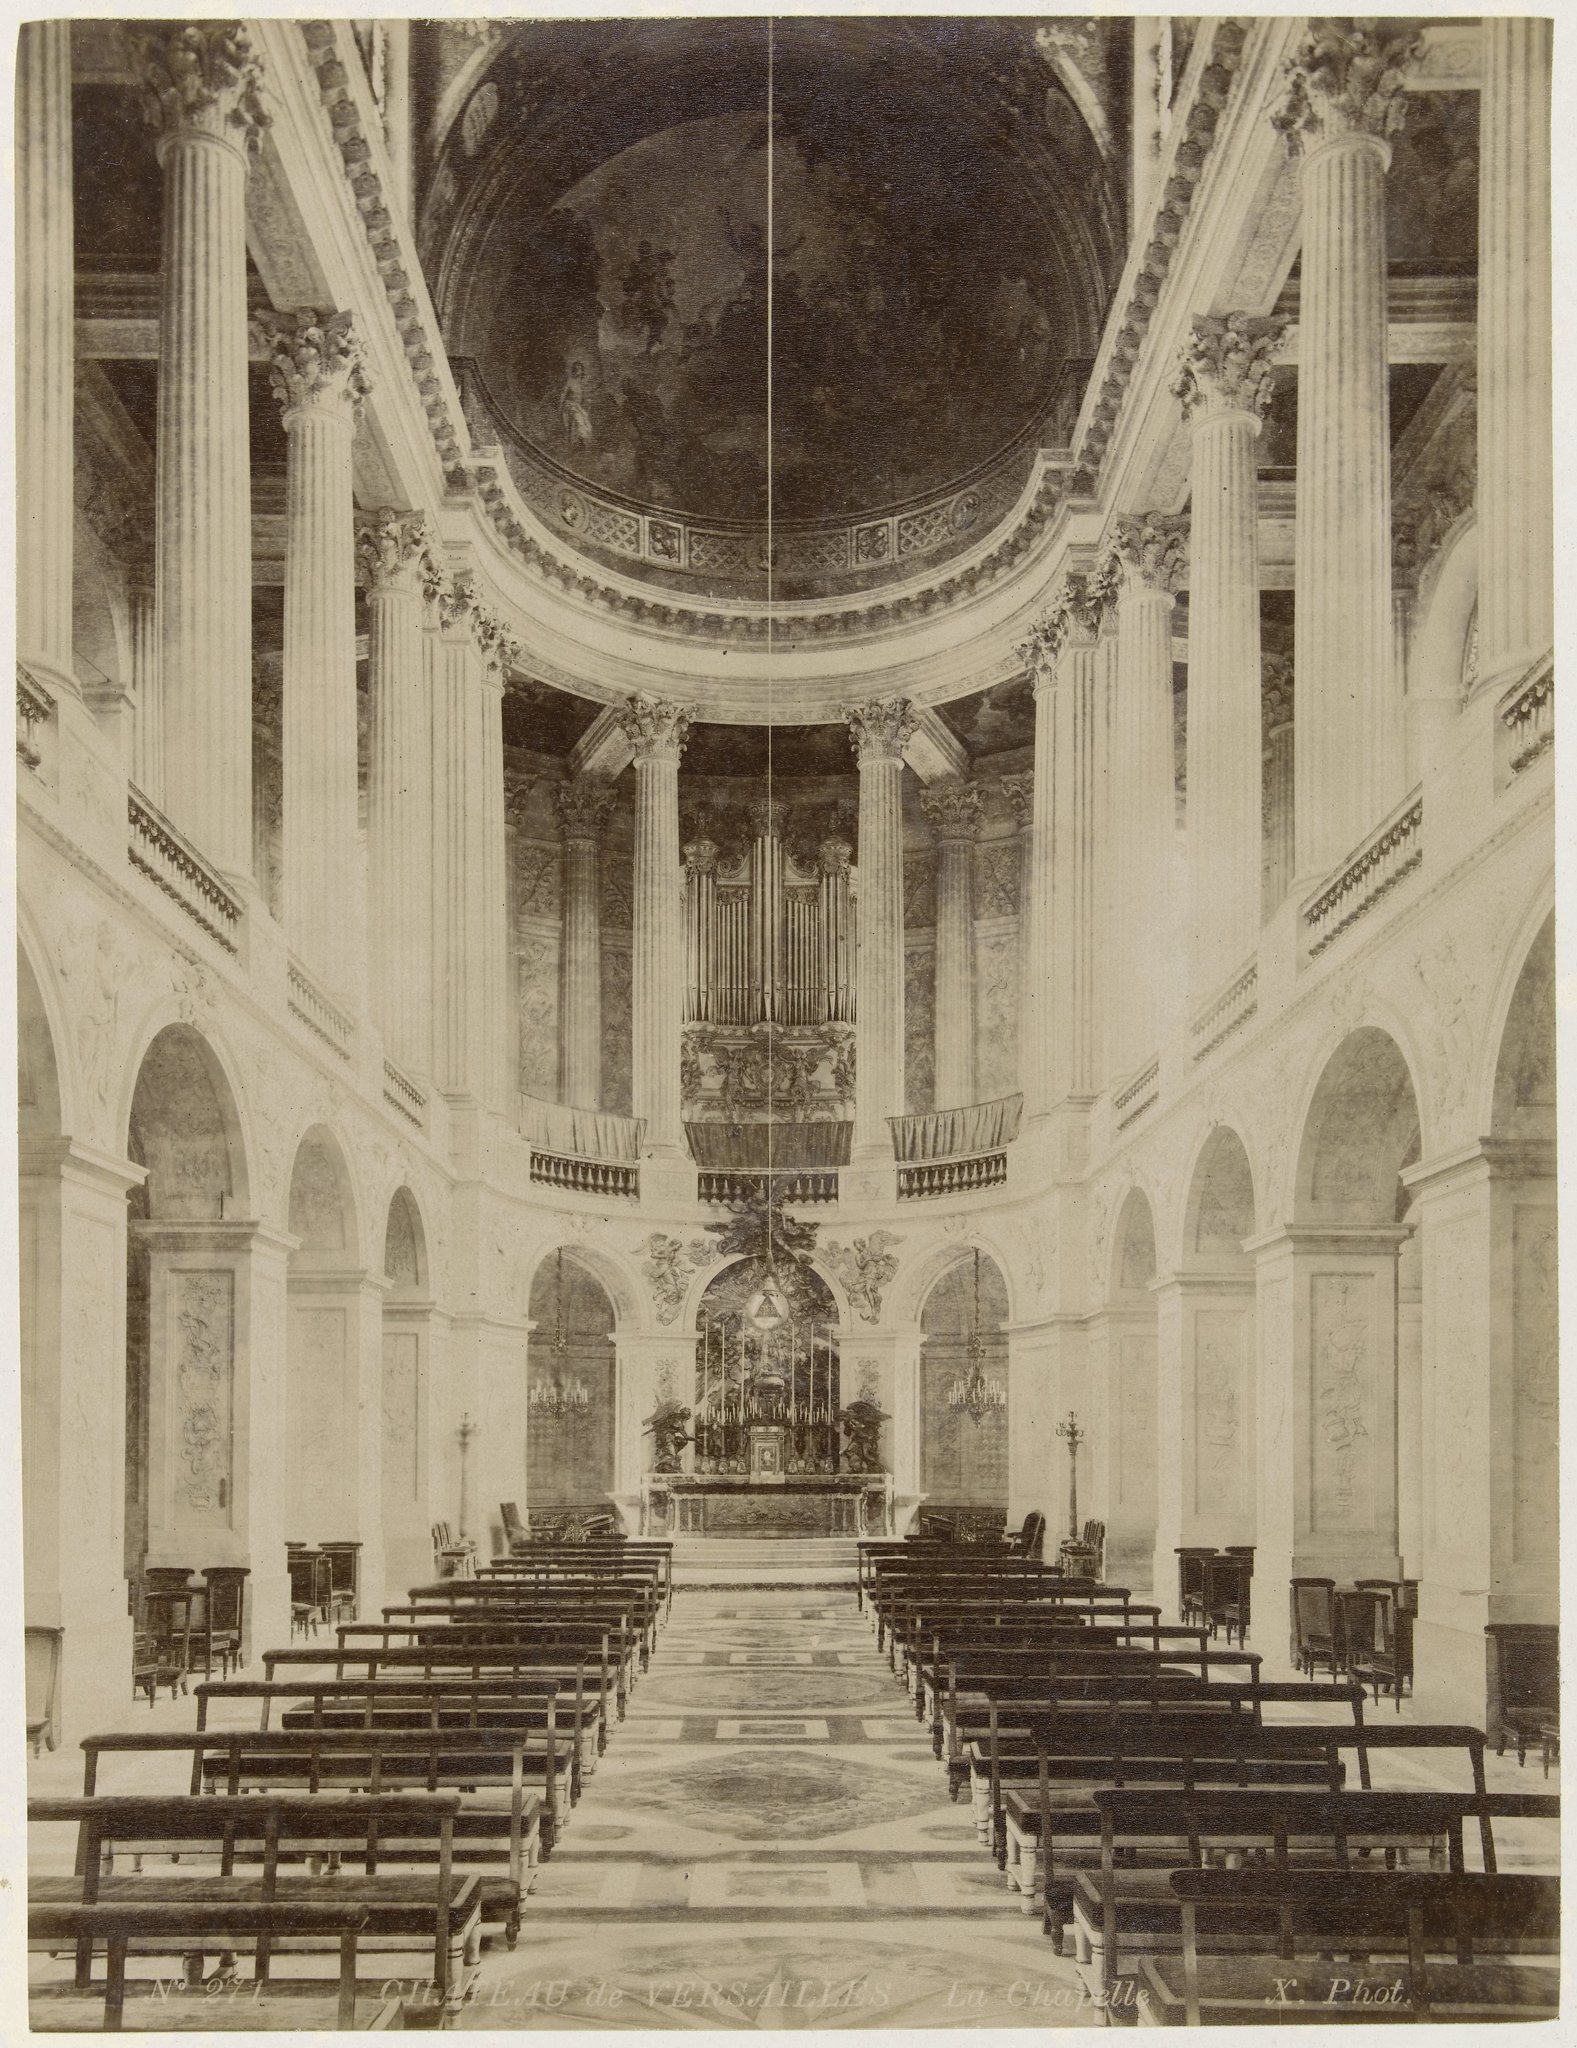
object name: photograph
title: Kapel in het paleis van Versailles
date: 1887-1900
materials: cardboard, paper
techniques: albumen print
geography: versailles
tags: interior of church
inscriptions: inscription: ‘No 271. Château de Versailles. La Chapelle X. Phot.’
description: Tussen 1887 en ca. 1900 werkten Neurdein frères onder andere onder de naam 'X phot.'.